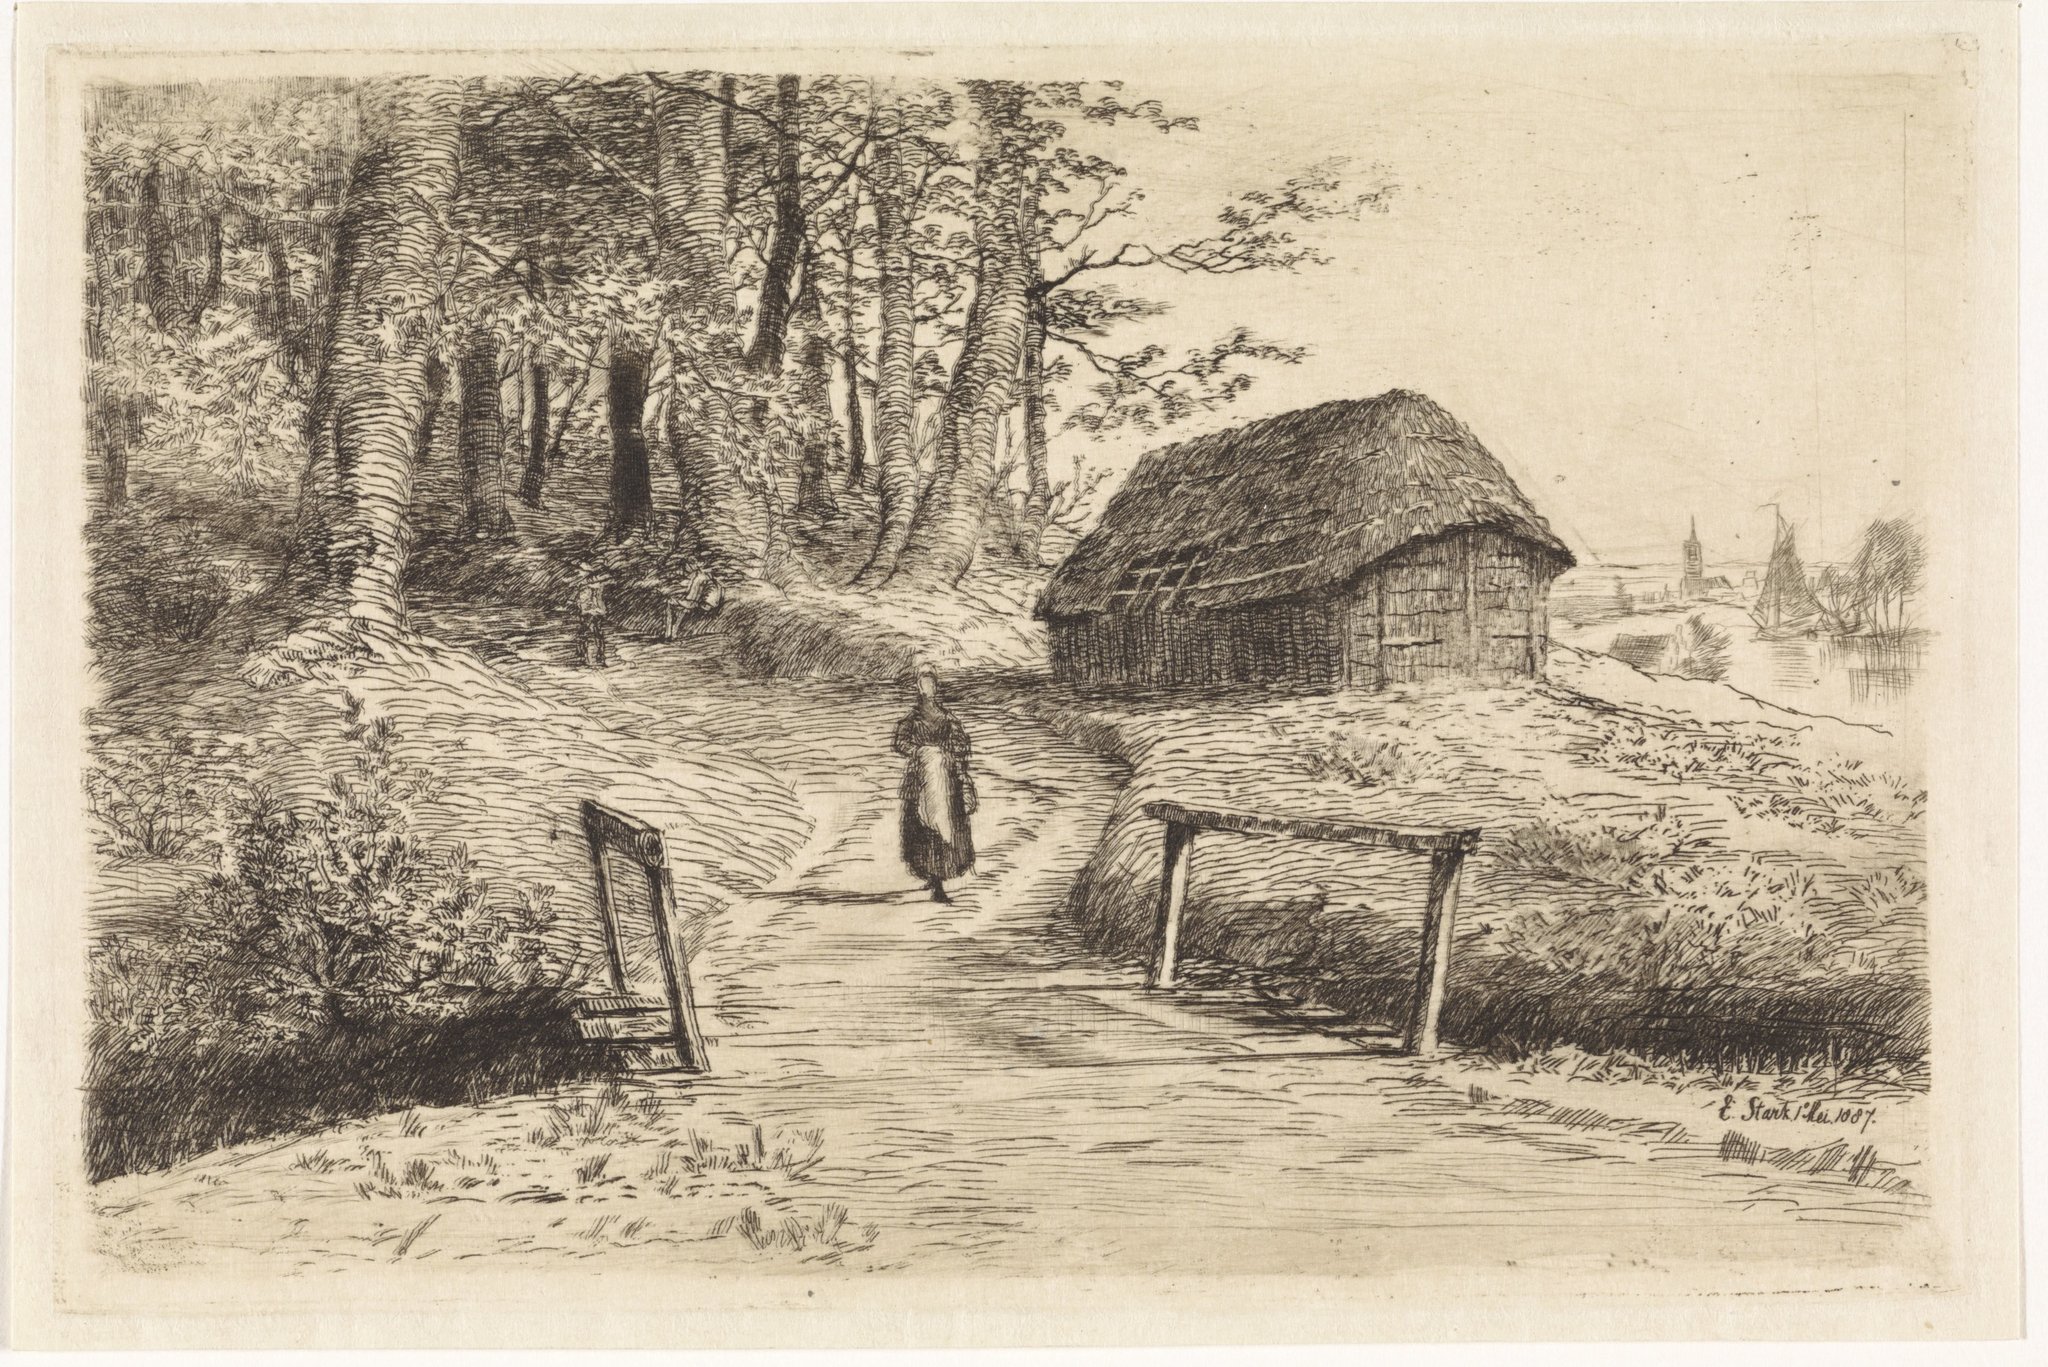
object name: print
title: Landschap met bruggetje en schuur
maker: elias stark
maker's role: draughtsman, print maker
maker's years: 1849-1933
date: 1887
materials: paper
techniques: etching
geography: nieuwer-amstel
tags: barn, bridge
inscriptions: collector's mark: Lugt 2228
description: Een vrouw loopt een weg, die over een bruggetje en langs een schuur leidt.